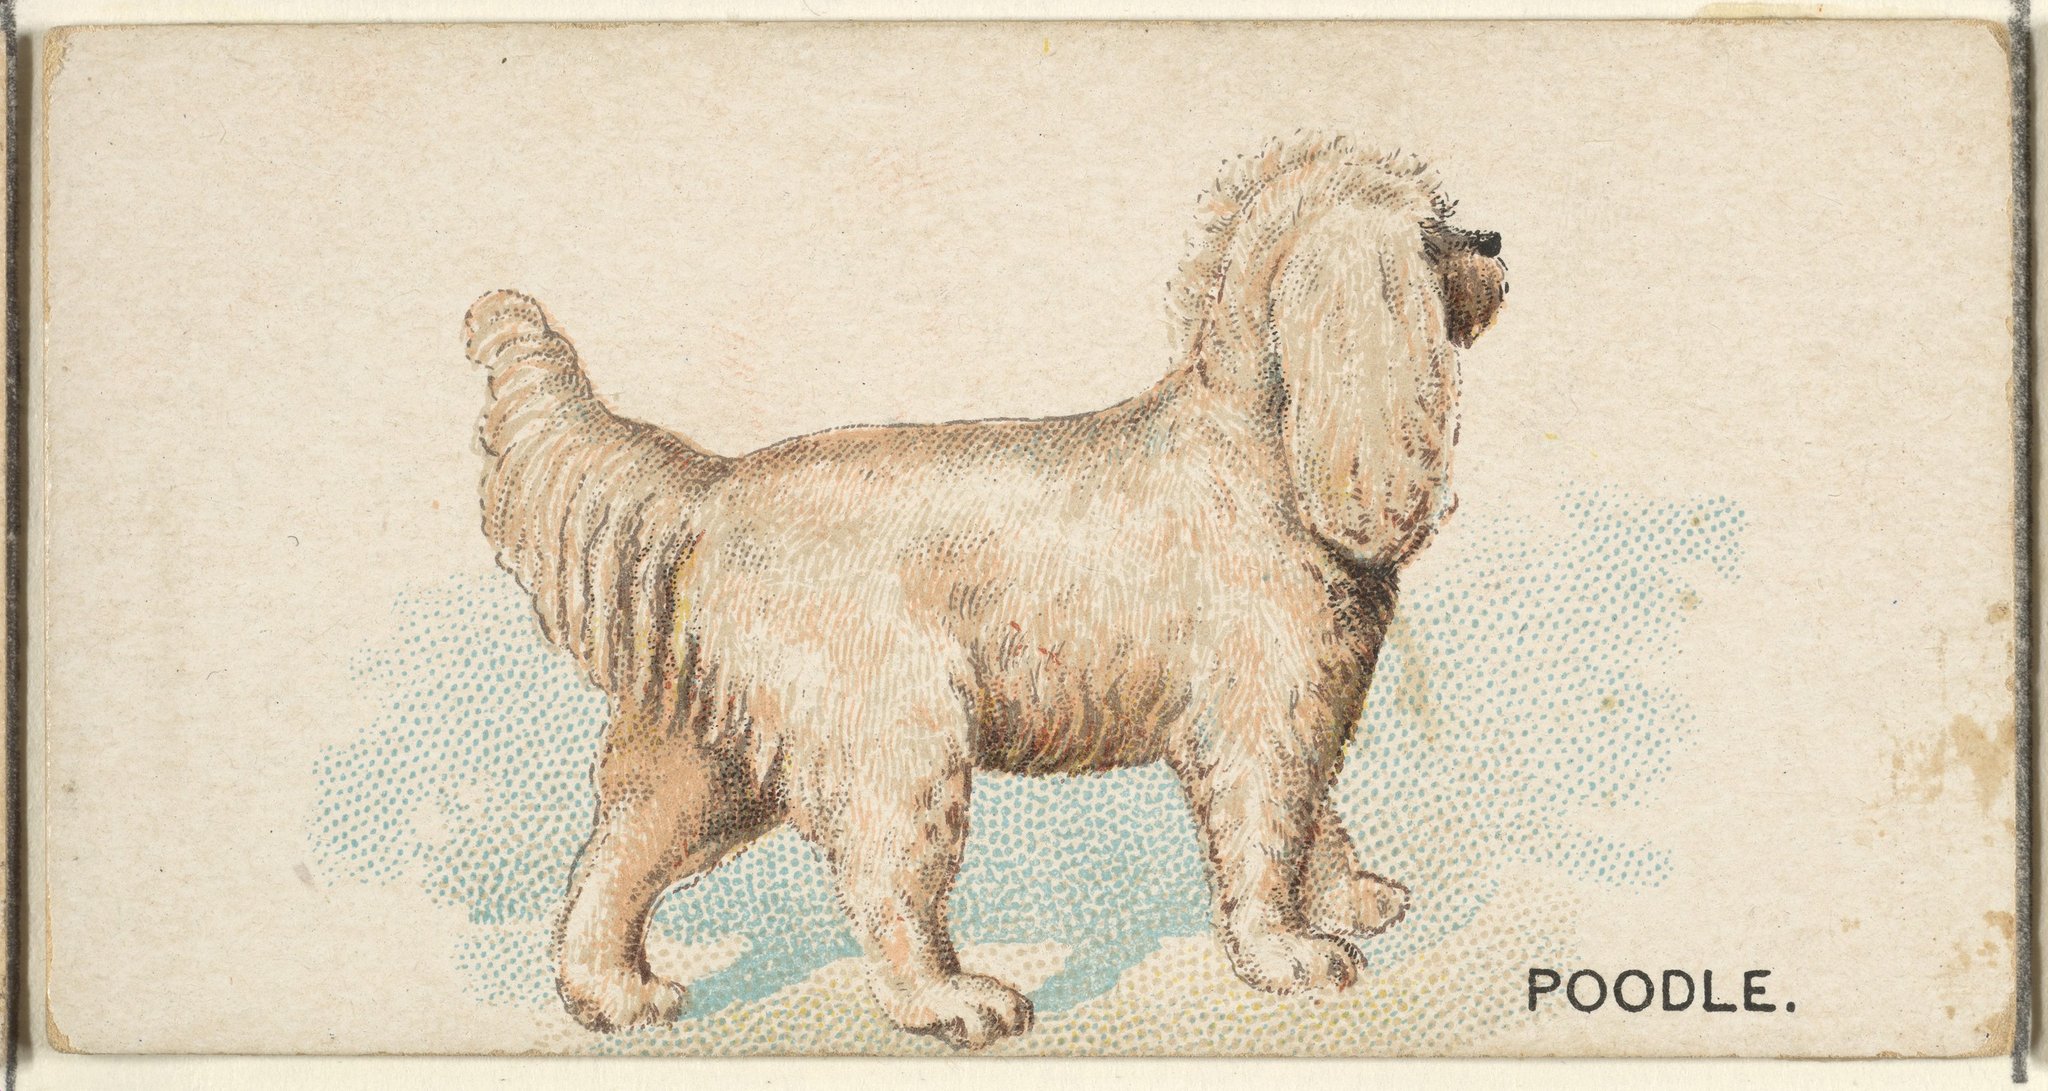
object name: print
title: Poodle, from the Dogs of the World series for Old Judge Cigarettes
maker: goodwin & company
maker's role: publisher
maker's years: 1850-1950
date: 1890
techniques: color lithograph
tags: dogs